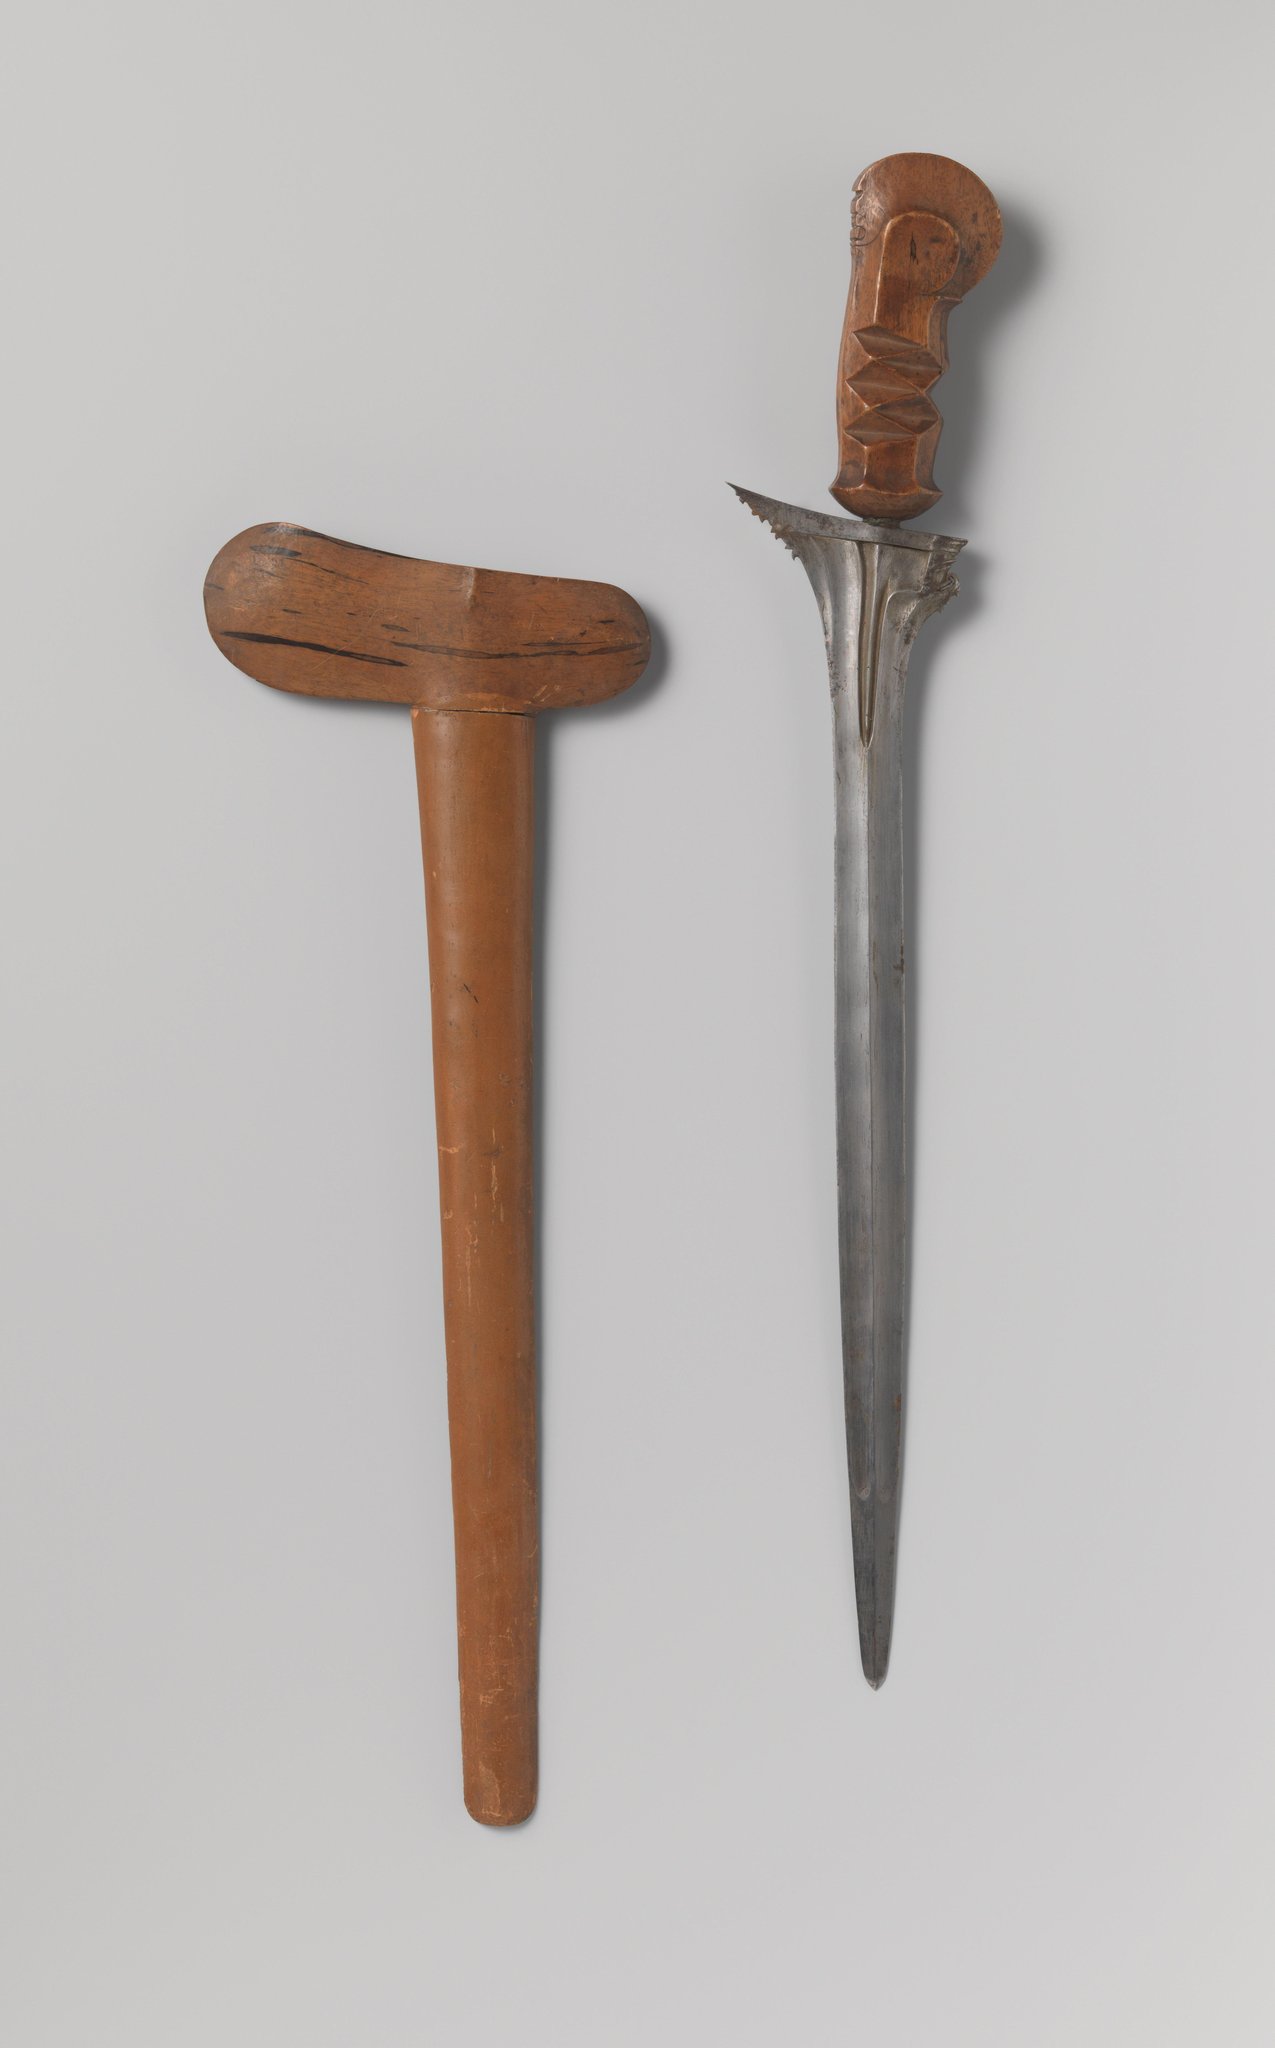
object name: kris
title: Kris van Bali met schede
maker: Anonymous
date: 1800-1899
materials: steel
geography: bali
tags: lombok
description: Kris van Bali, het staal bij het gevest sierlijk uitgesmeed, in meer dan helft geel geverfde schede. Buitgemaakt op de expeditie van Lombok in 1894.